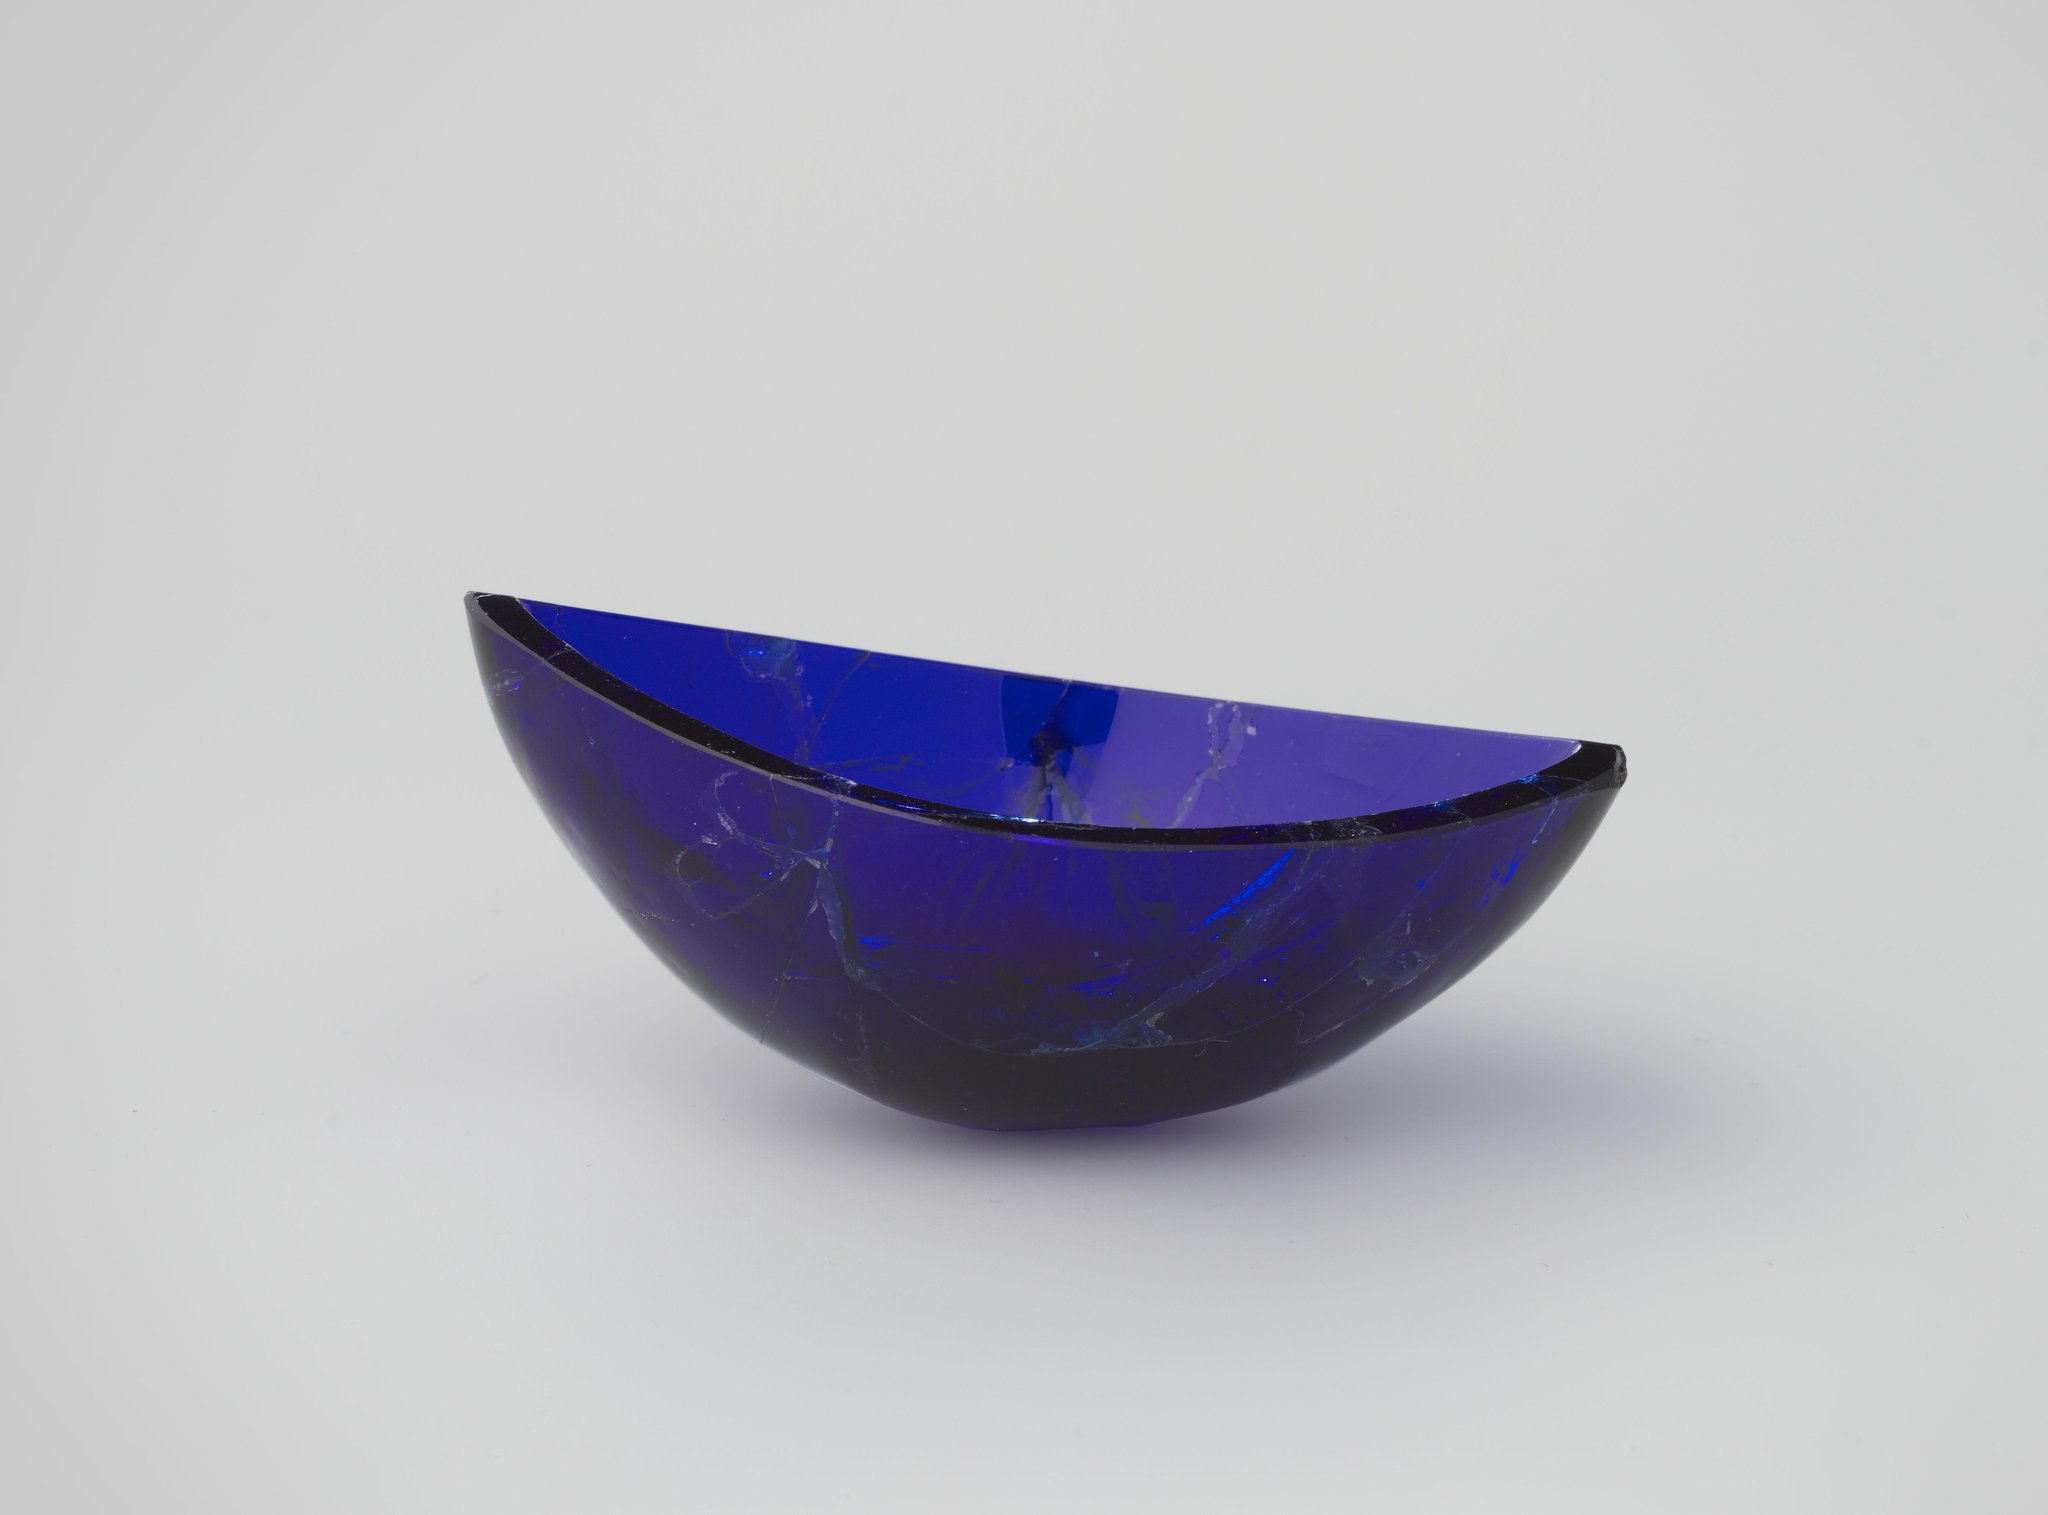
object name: salt condiment vessel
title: Binnenbak van zoutvat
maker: christiaan mensink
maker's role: silversmith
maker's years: 1770-1839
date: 1803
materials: glass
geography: amsterdam